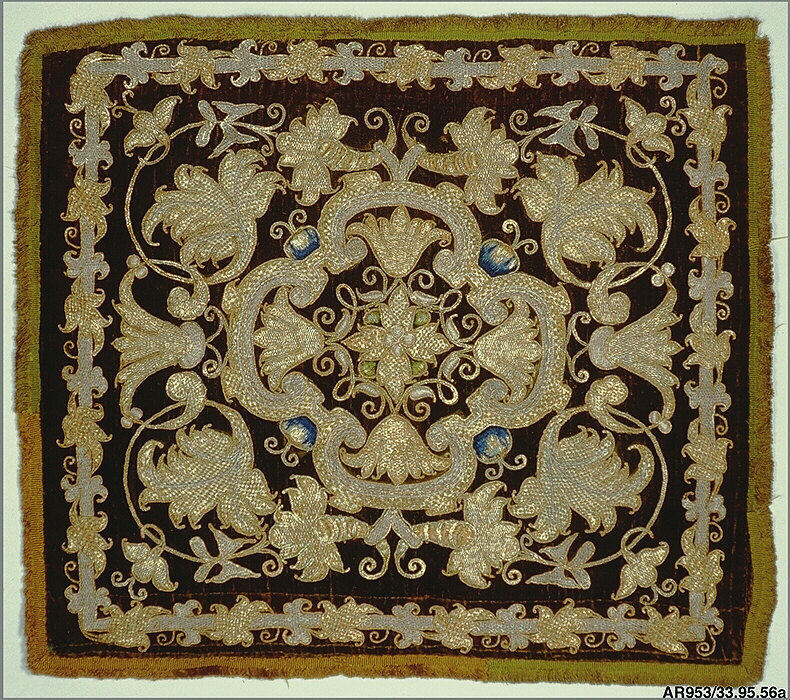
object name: clothing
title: Apparel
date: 1801-1900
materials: metal thread, silk, velvet